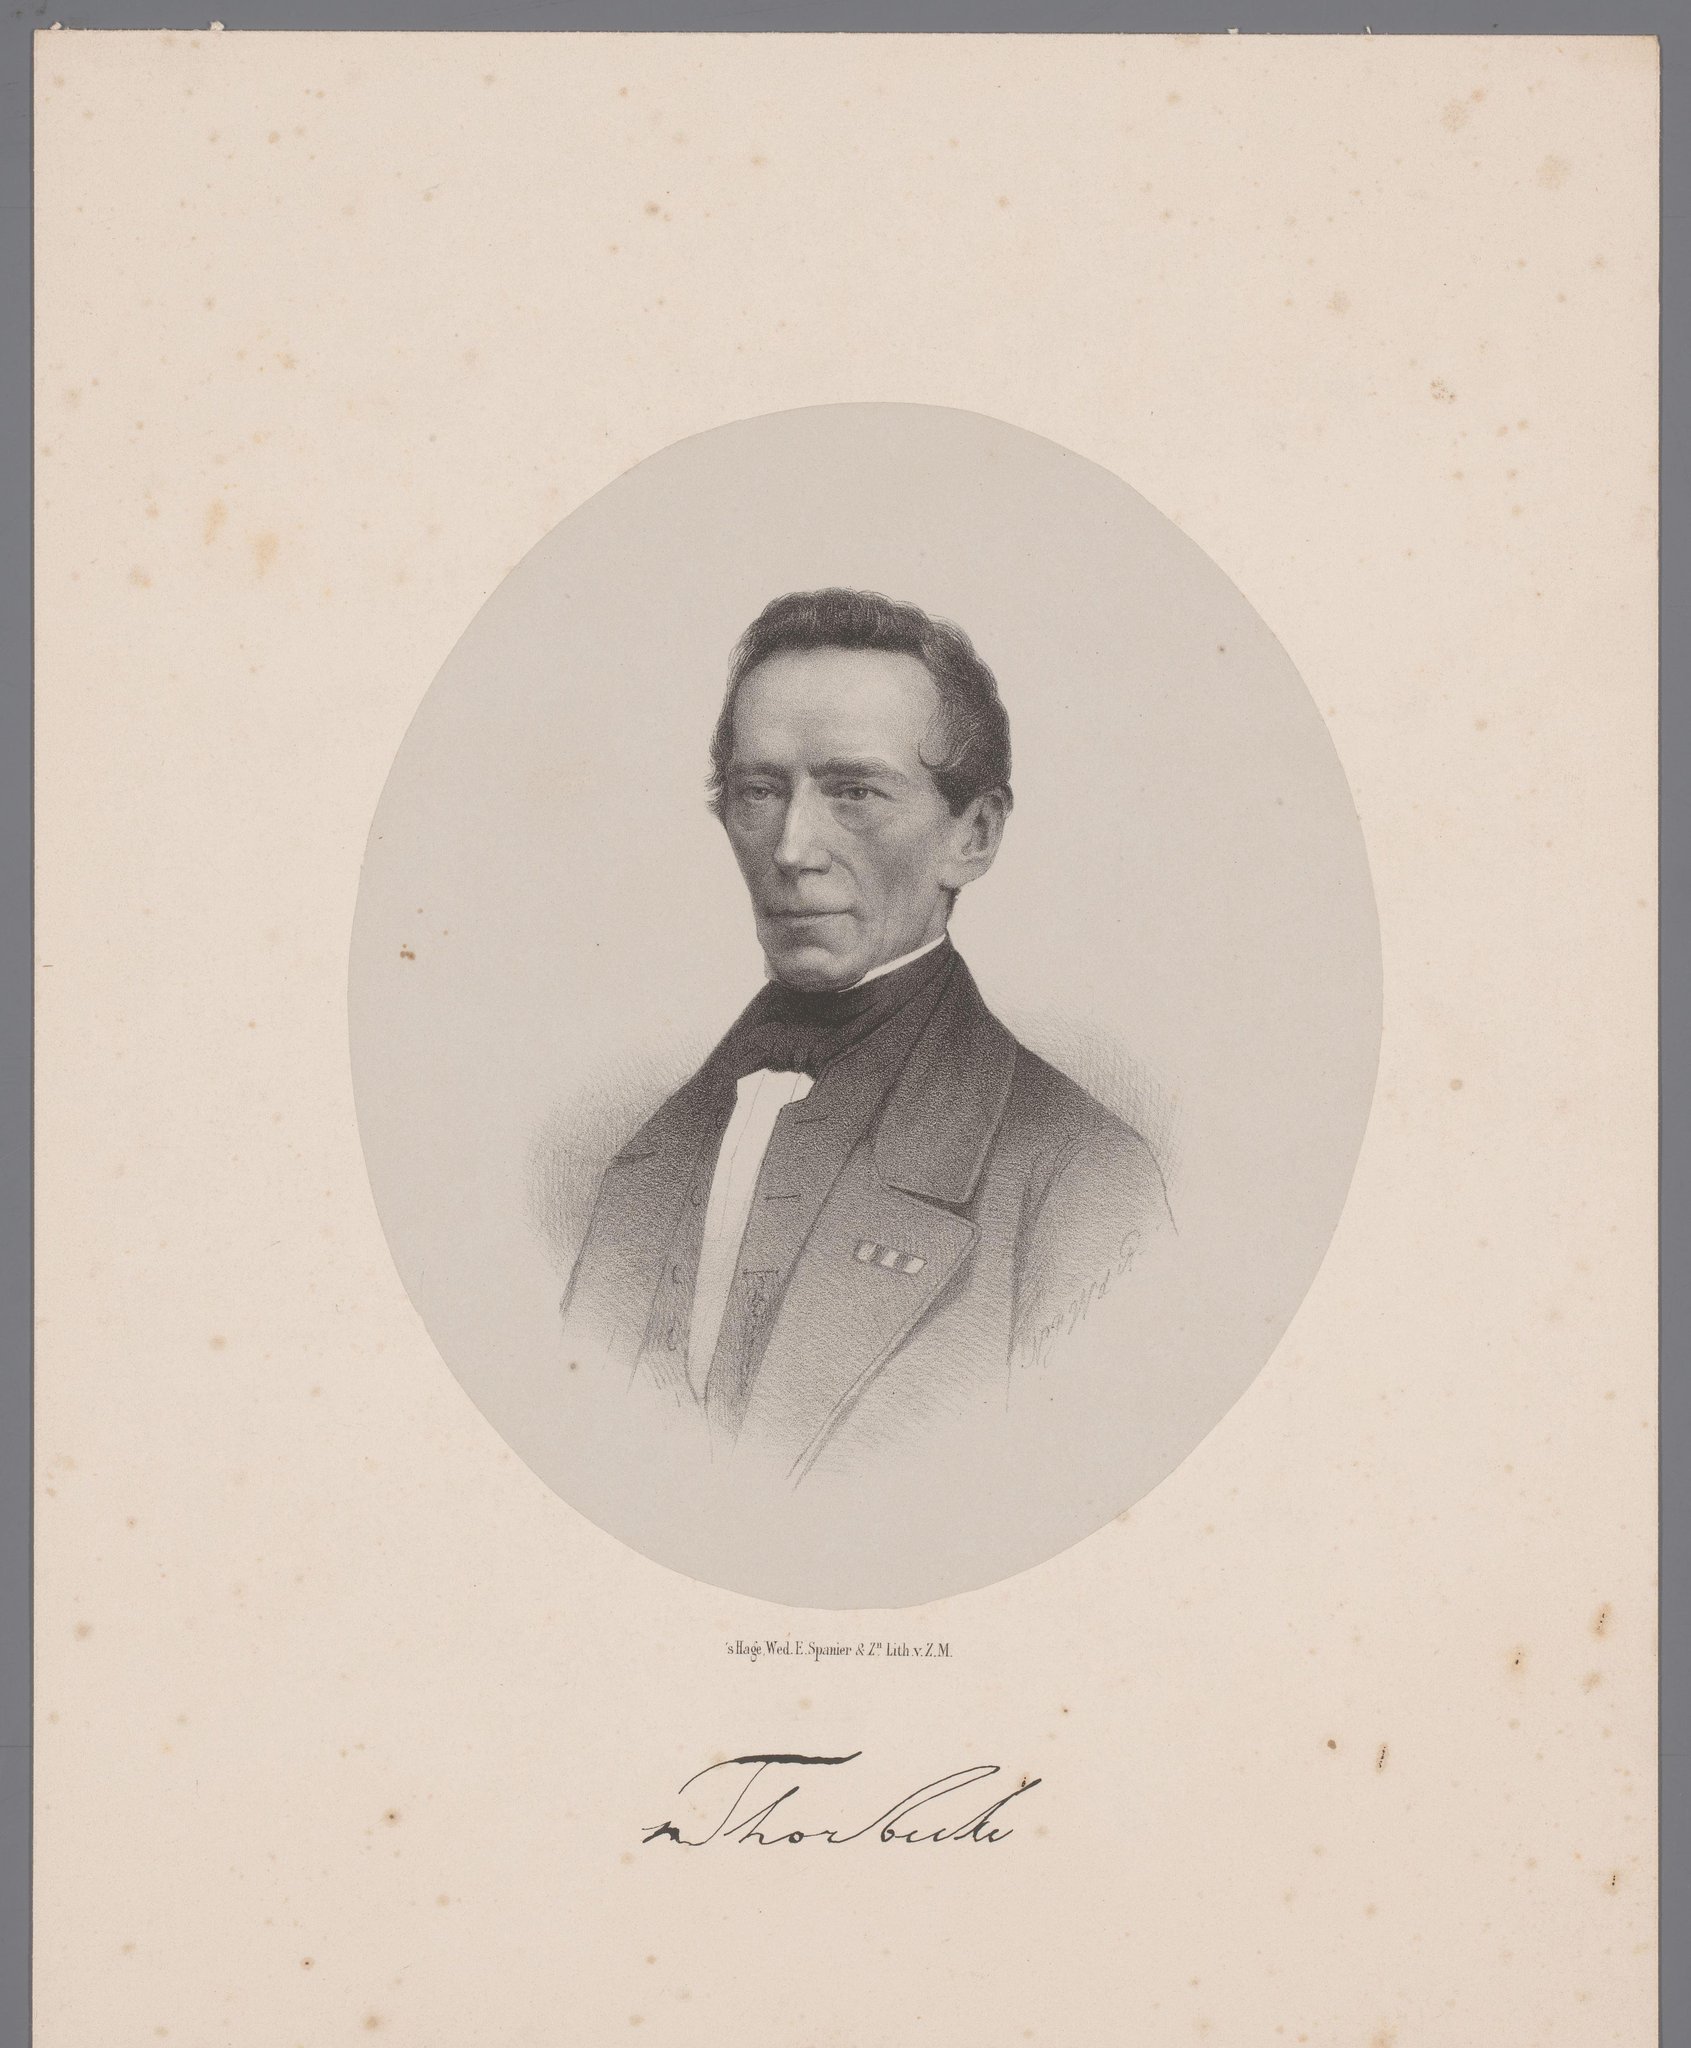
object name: print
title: Thorbecke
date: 1863-1872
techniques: lithograph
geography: the hague